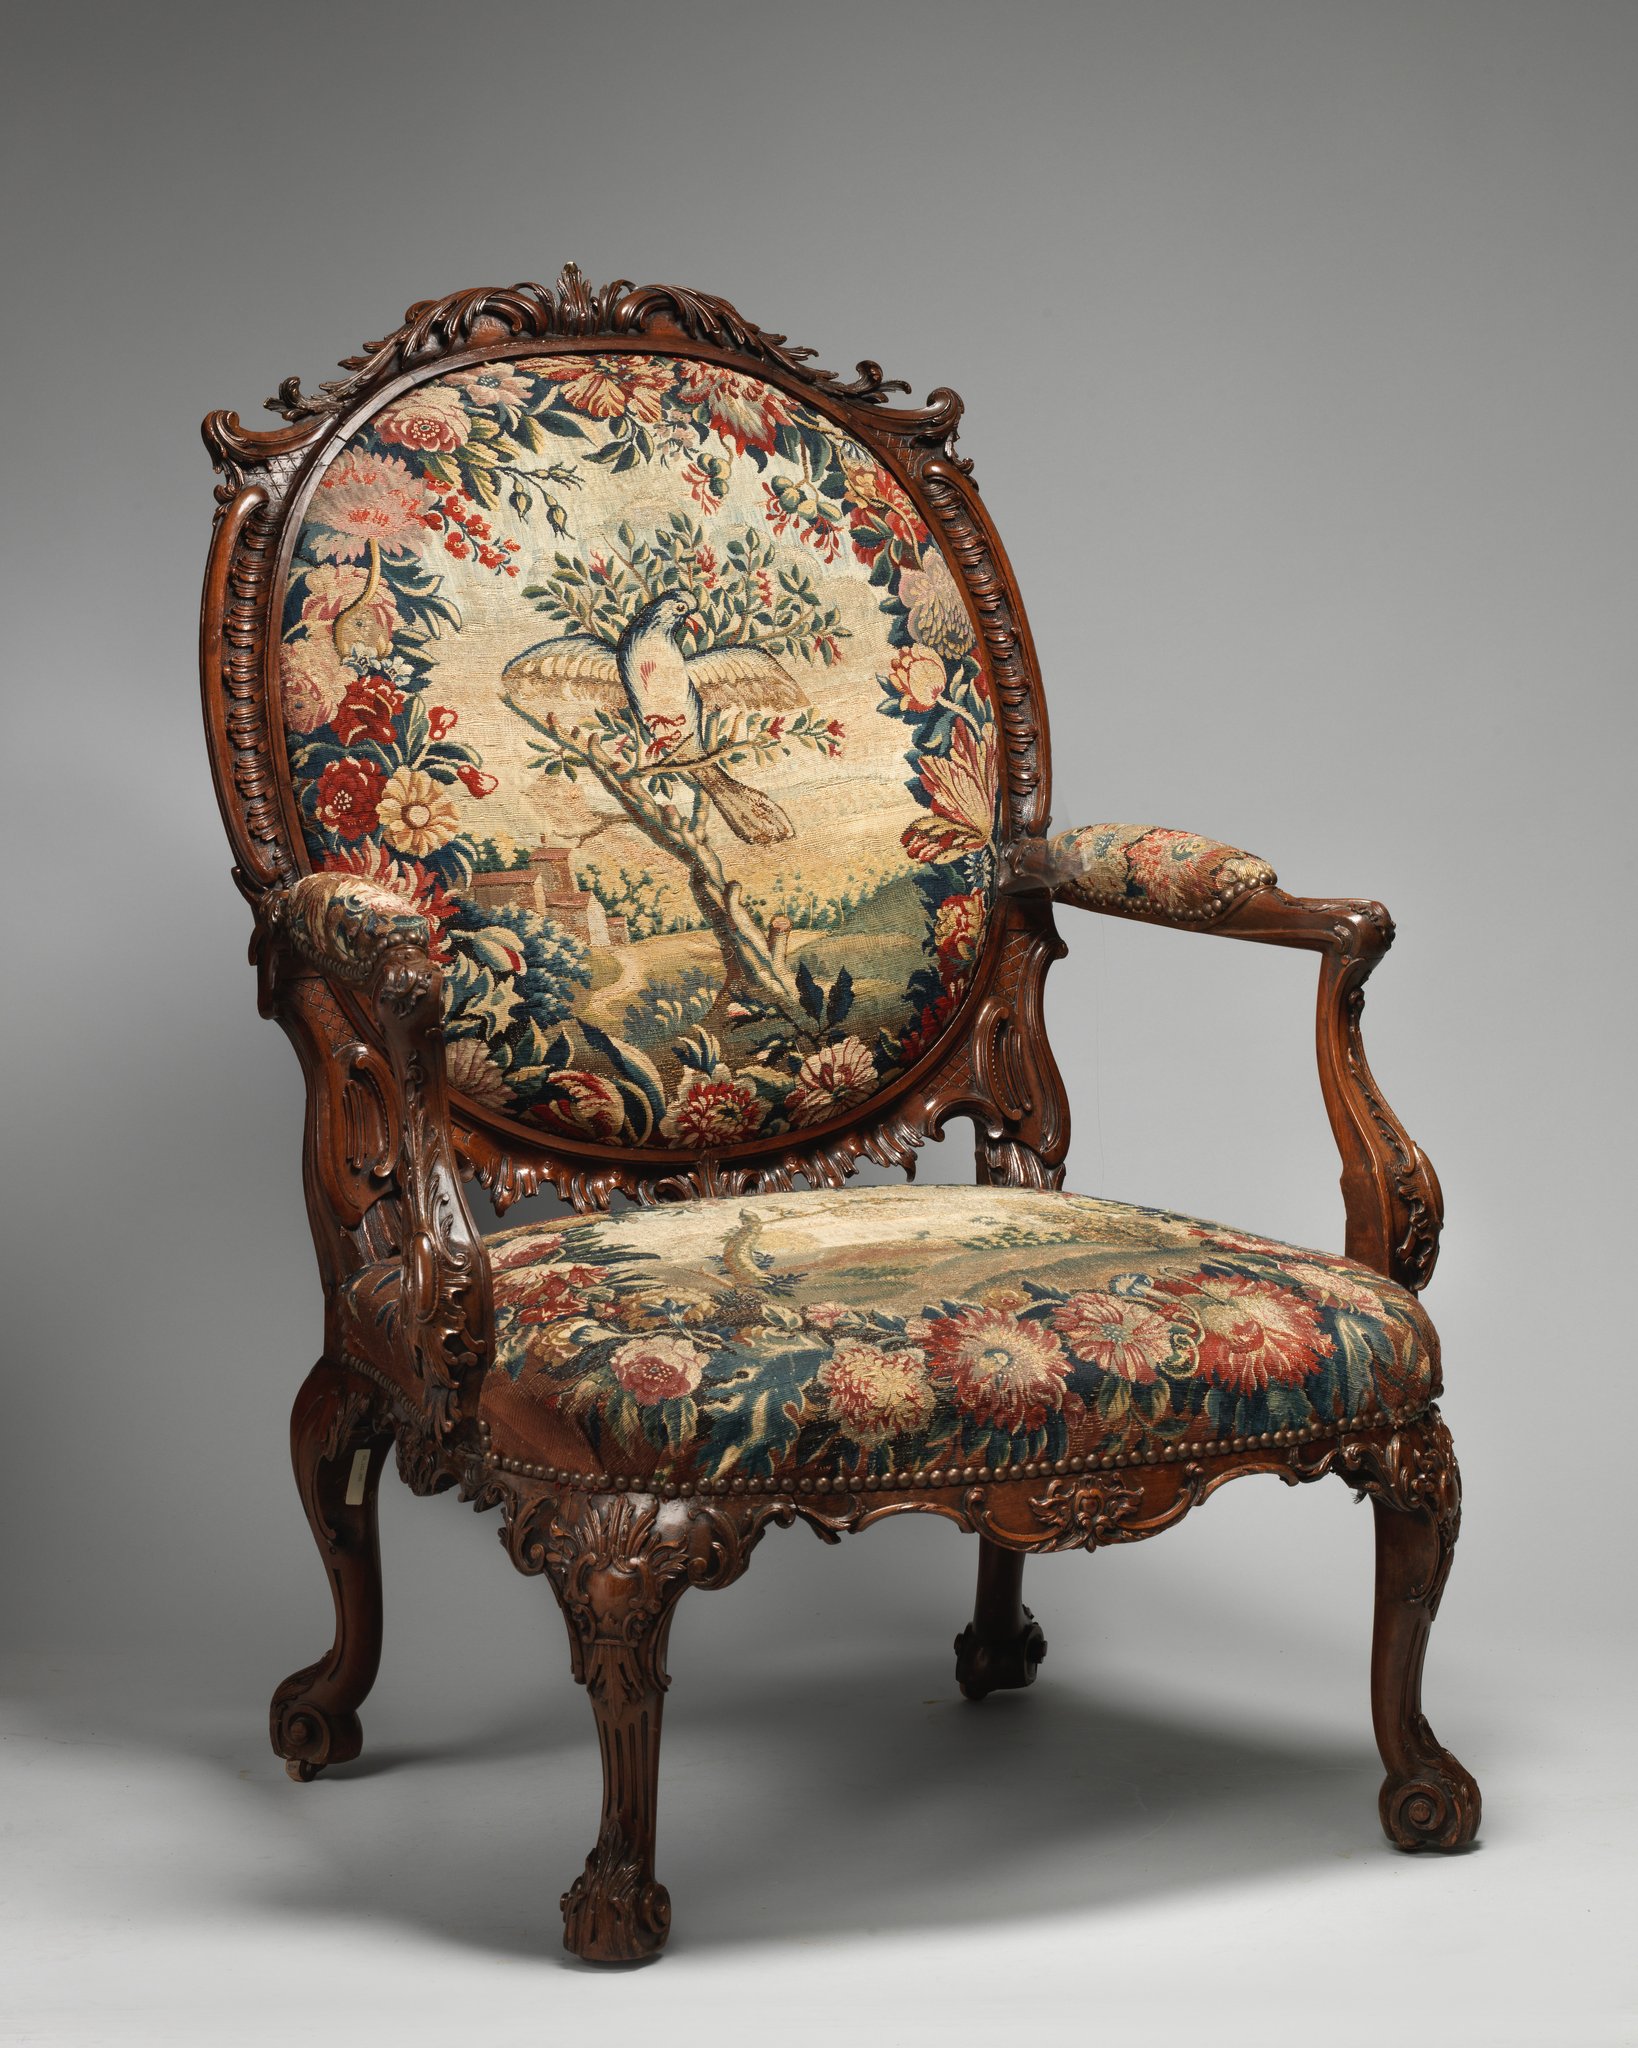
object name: armchair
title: Armchair (one of four)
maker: royal manufactory beauvais 1664-1789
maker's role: factory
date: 1755-1765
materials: wood, silk, wool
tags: birds,houses,flowers,trees